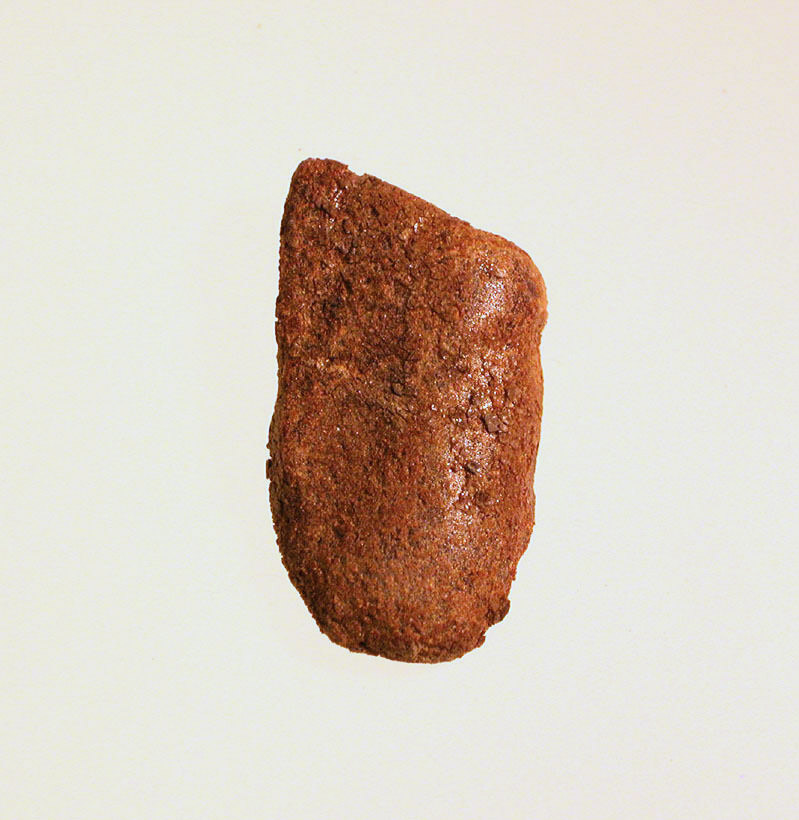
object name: head of a woman to right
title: Pendant: head of a woman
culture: italic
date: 500-401 BCE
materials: amber